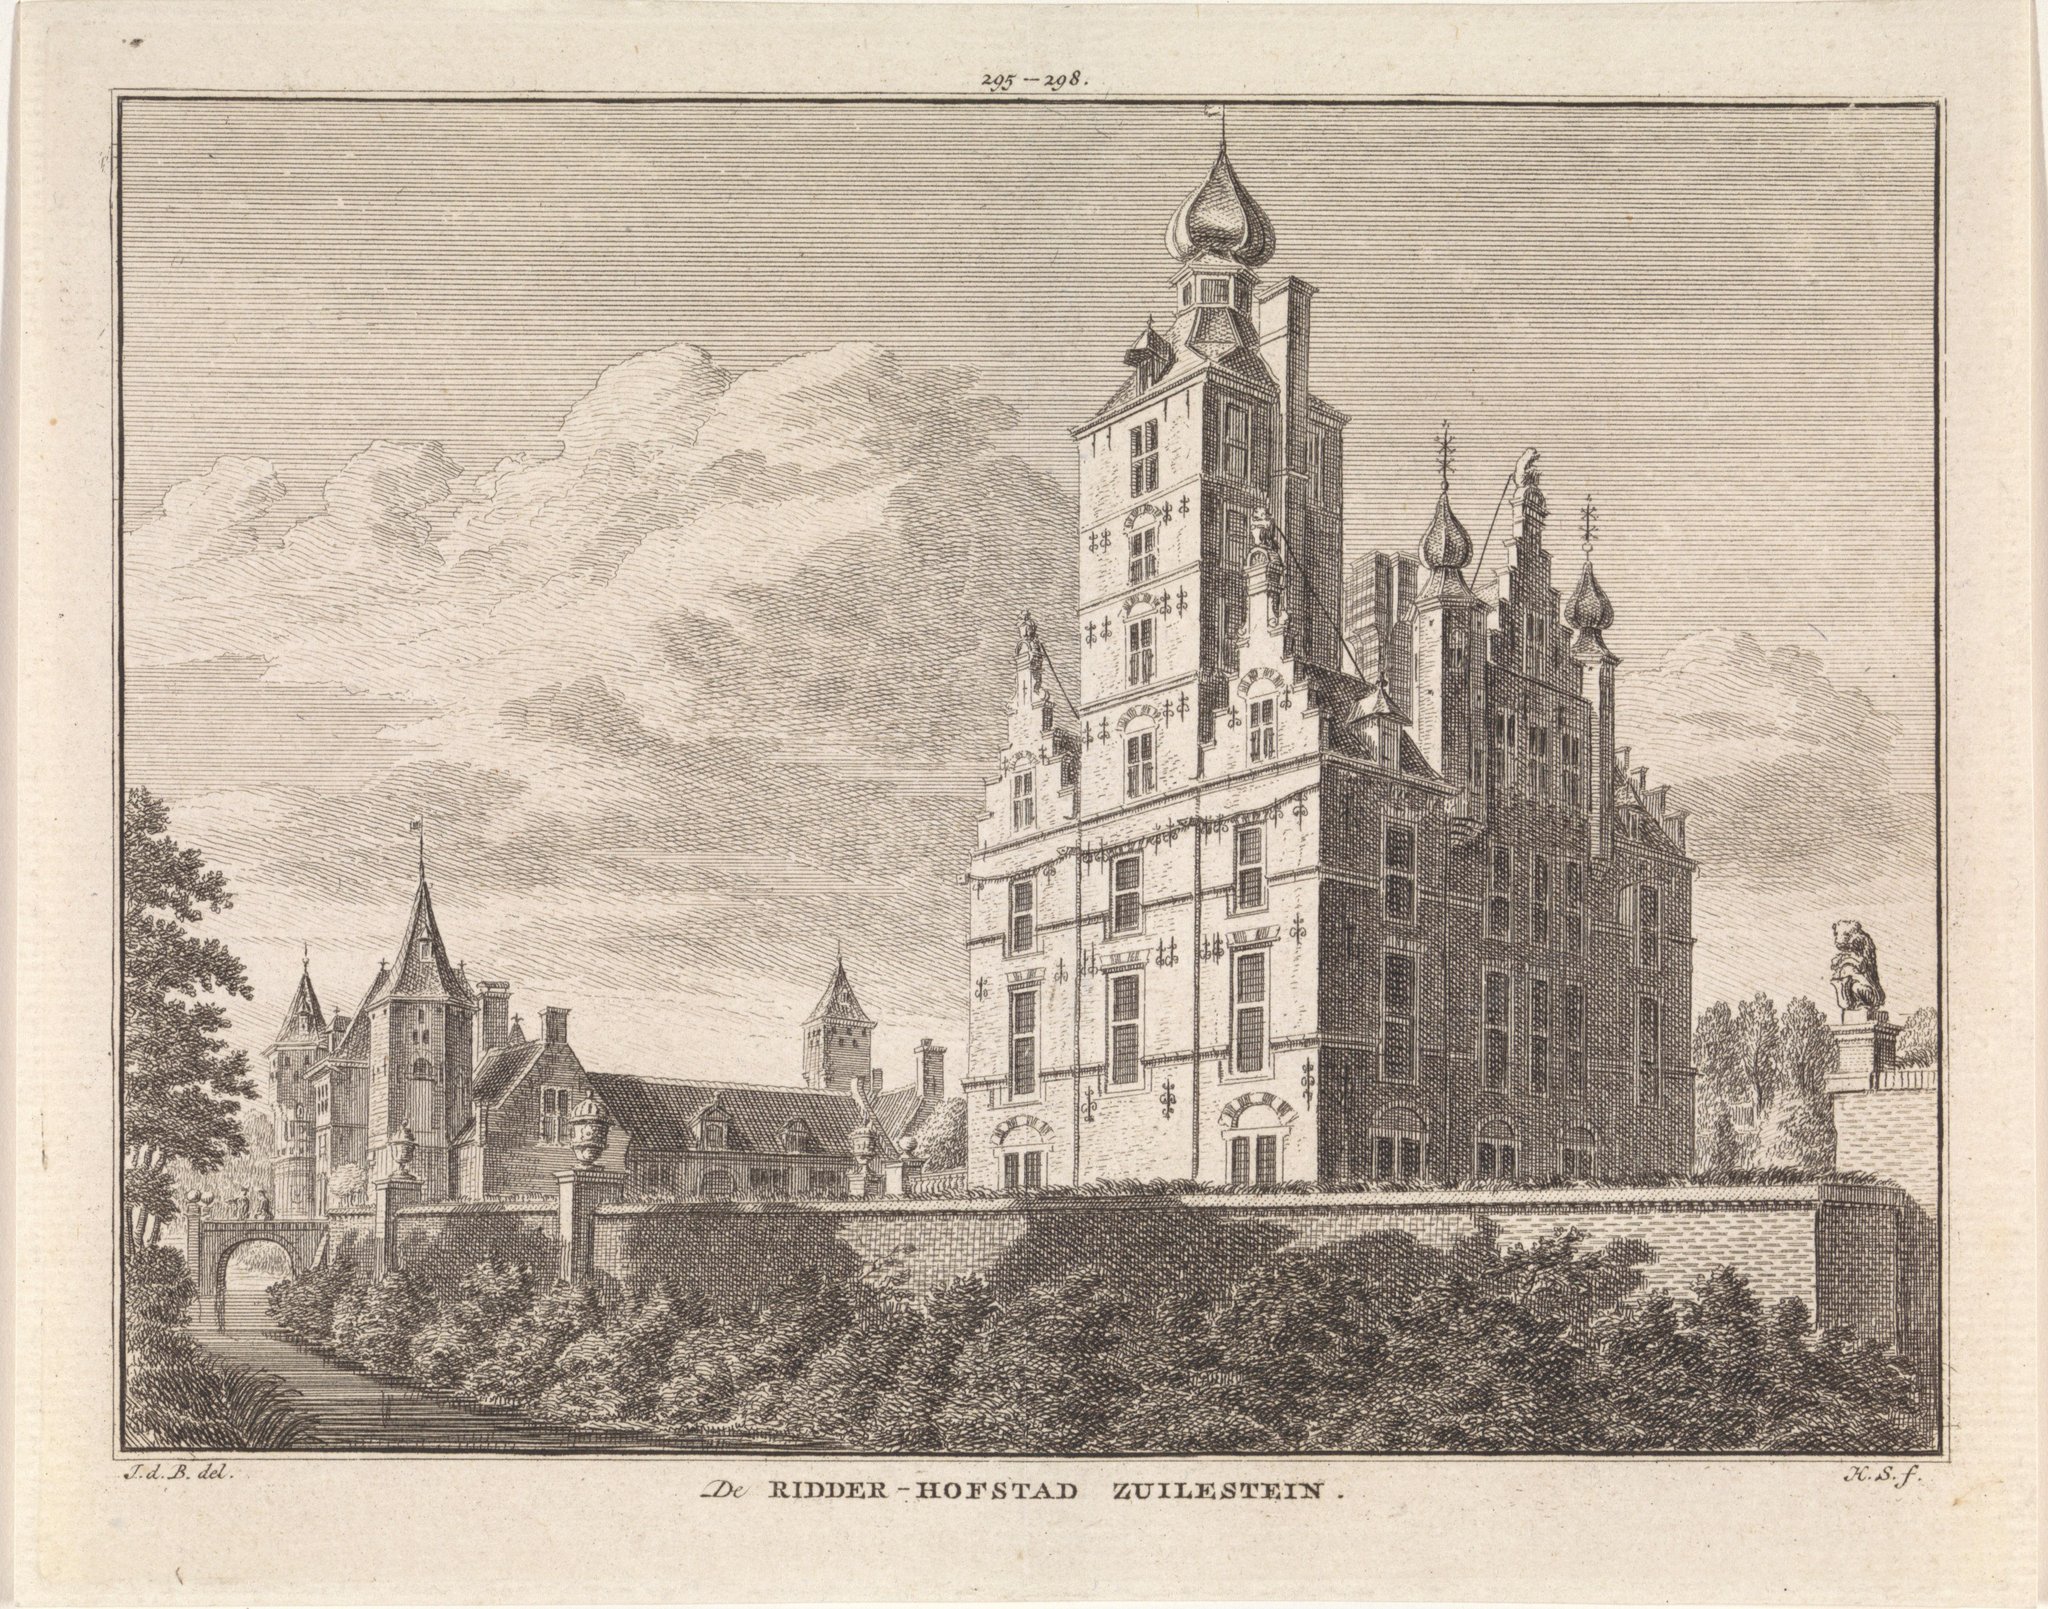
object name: print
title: De ridder-hofstad Zuilestein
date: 1774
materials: paper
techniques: etching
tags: castle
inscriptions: collector's mark: Lugt 2228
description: Prent gebruikt in: Het verheerlykt Nederland of kabinet van hedendaagsche gezigten van steden, dorpen, sloten ... en andere voornaame stad- en landgebouwen, in en omtrent alle de byzondere Vereenigde Nederlandsche Provinciën : gedurende de laatste jaaren door vermaarden kunsttekenaren na het leven getekent en ... in 't koper gebragt ... dienende tot opheldering der beschryvinge van den Tegenwoordigen Staat der Vereenigde Nederlanden. Deel IX, 1774. Amsterdam: Isaac Tirion, 1745-1774.